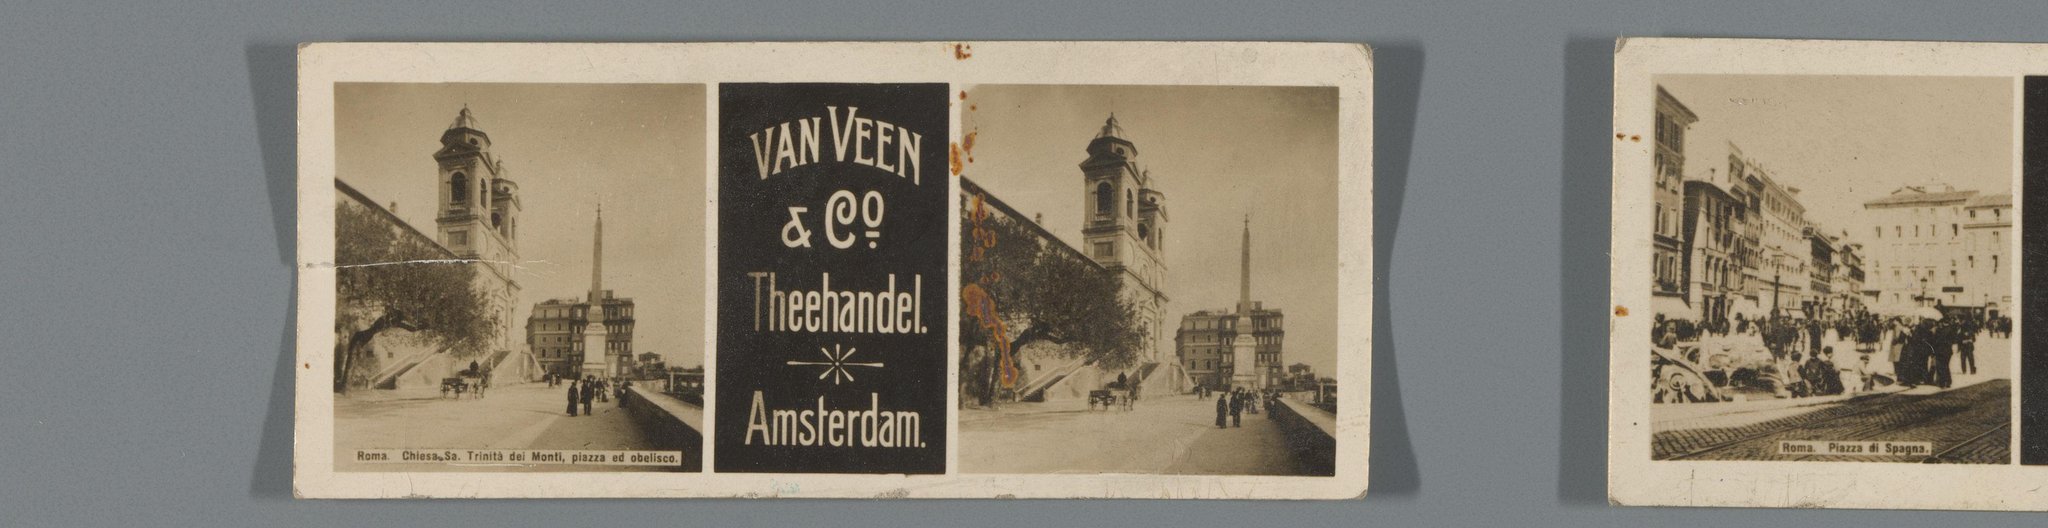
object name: stereograph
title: Gezicht op de Trinità dei Monti en de Obelisco Sallustiano in Rome, reclame voor Theehandel van Veen & Co.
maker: Anonymous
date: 1910-1920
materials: paper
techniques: gelatin silver print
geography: rome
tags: obelisk, needle, church (exterior)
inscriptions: inscription: ‘Stereoscopen voor deze plaatjes/ zijn verkrijgbaar à 25 cents per stuk/ bij VAN VEEN & Co., Amsterdam,/ Rotterdam, Den Haag, Nijmegen/ Haarlem en Hilversum.’